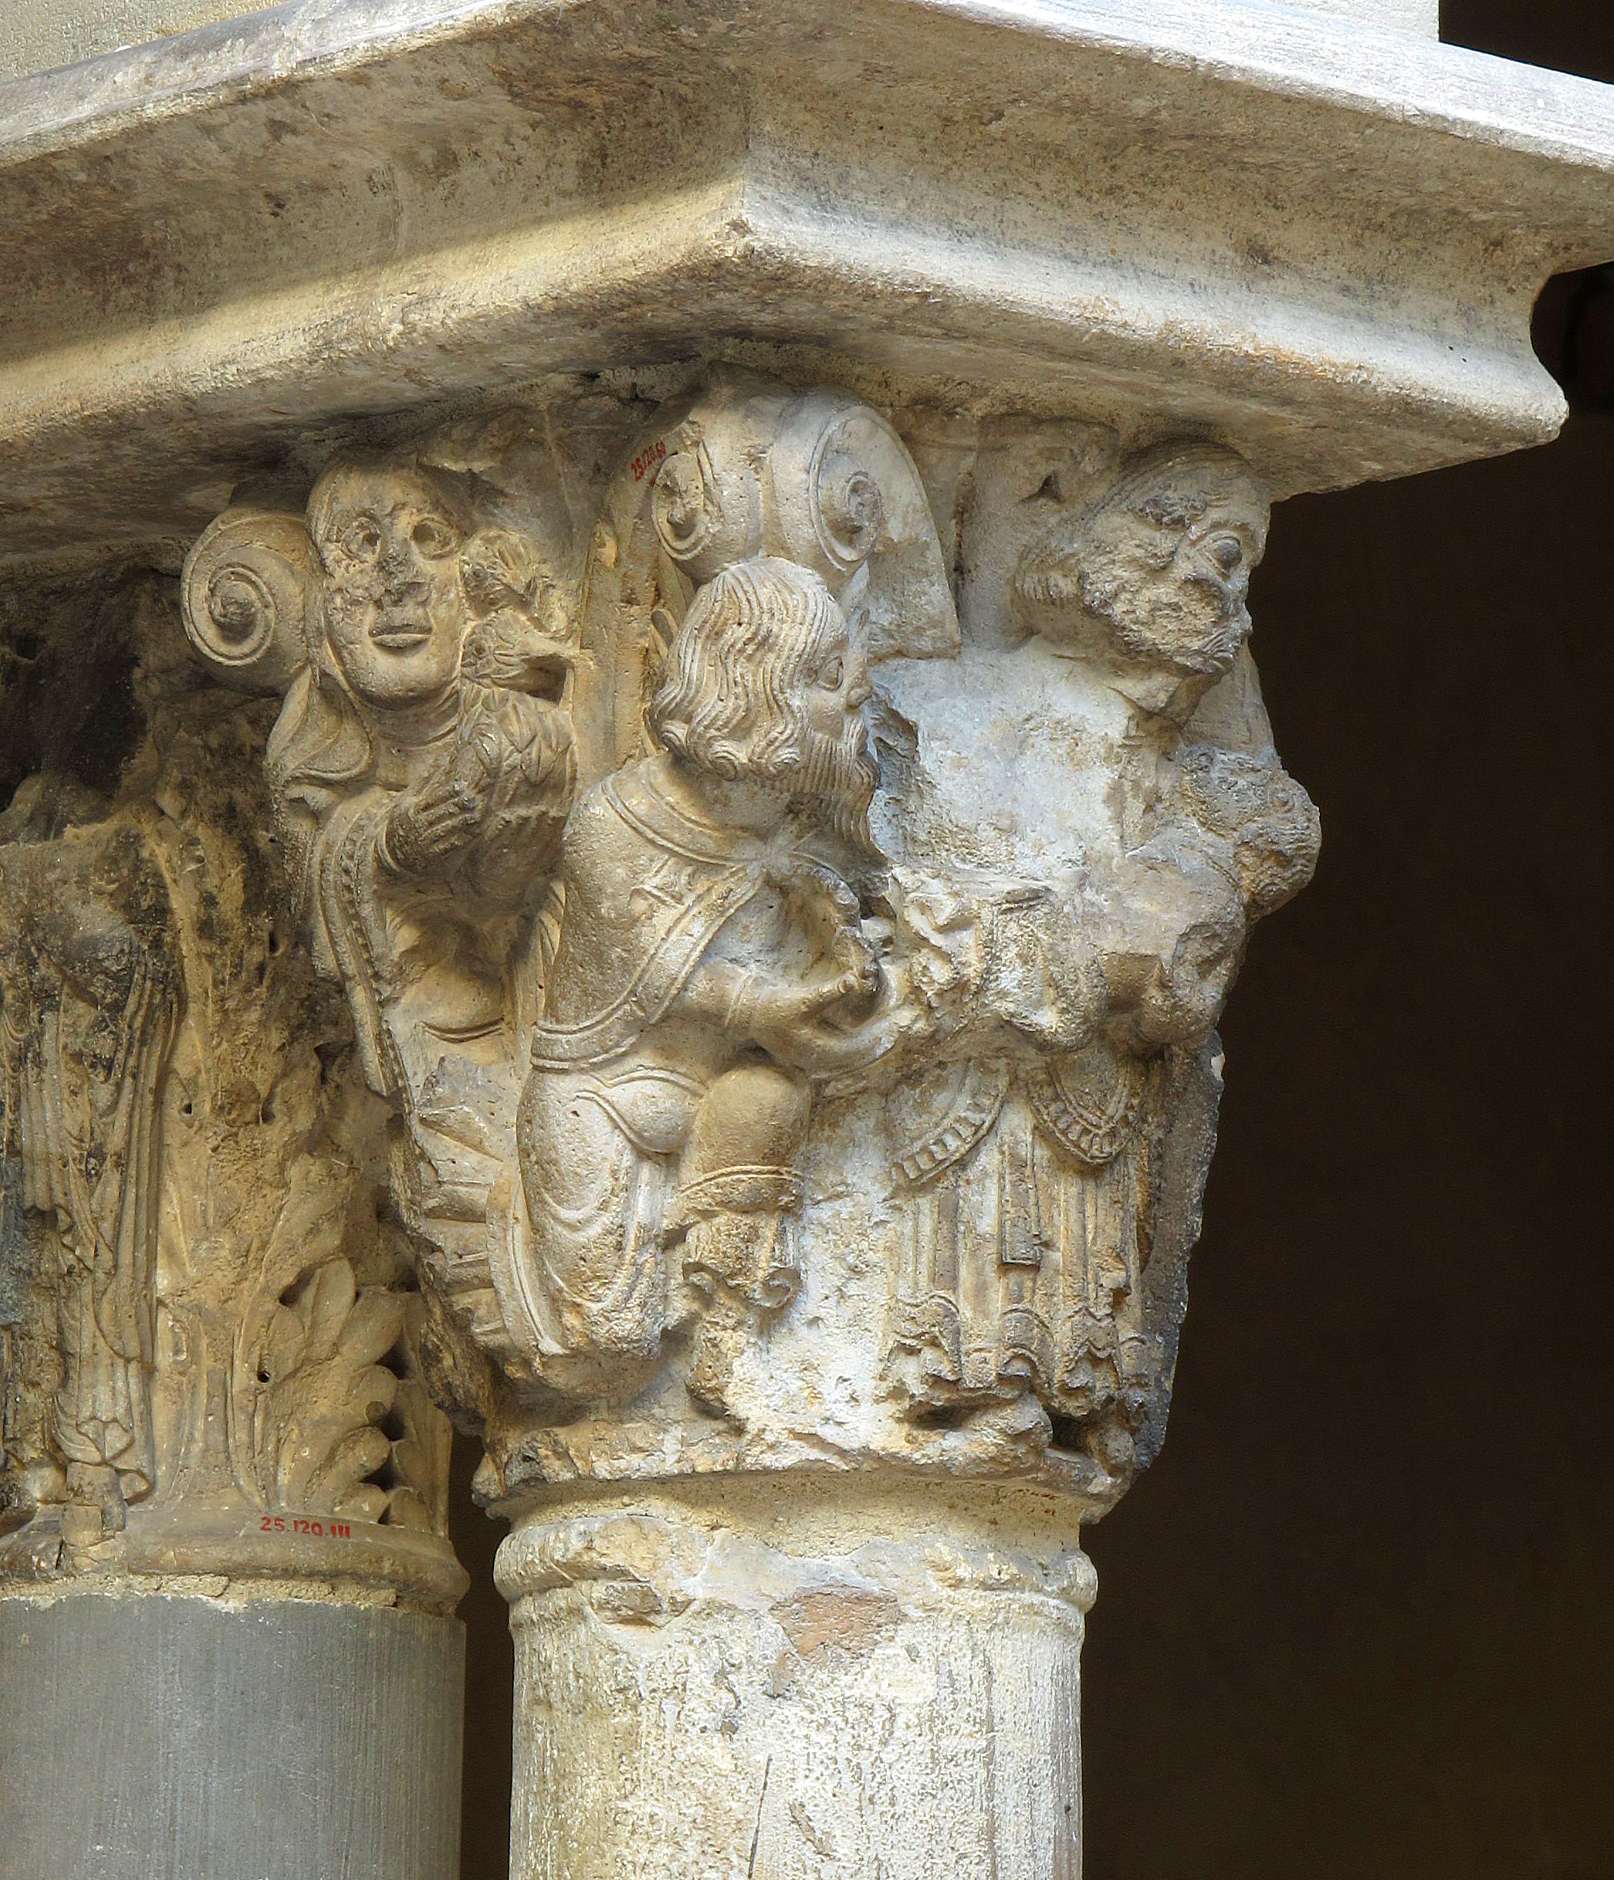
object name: capital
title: Capital with the Presentation of Christ in the Temple (from Saint-Guilhem Cloister)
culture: french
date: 1167-1233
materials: limestone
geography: france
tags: christ